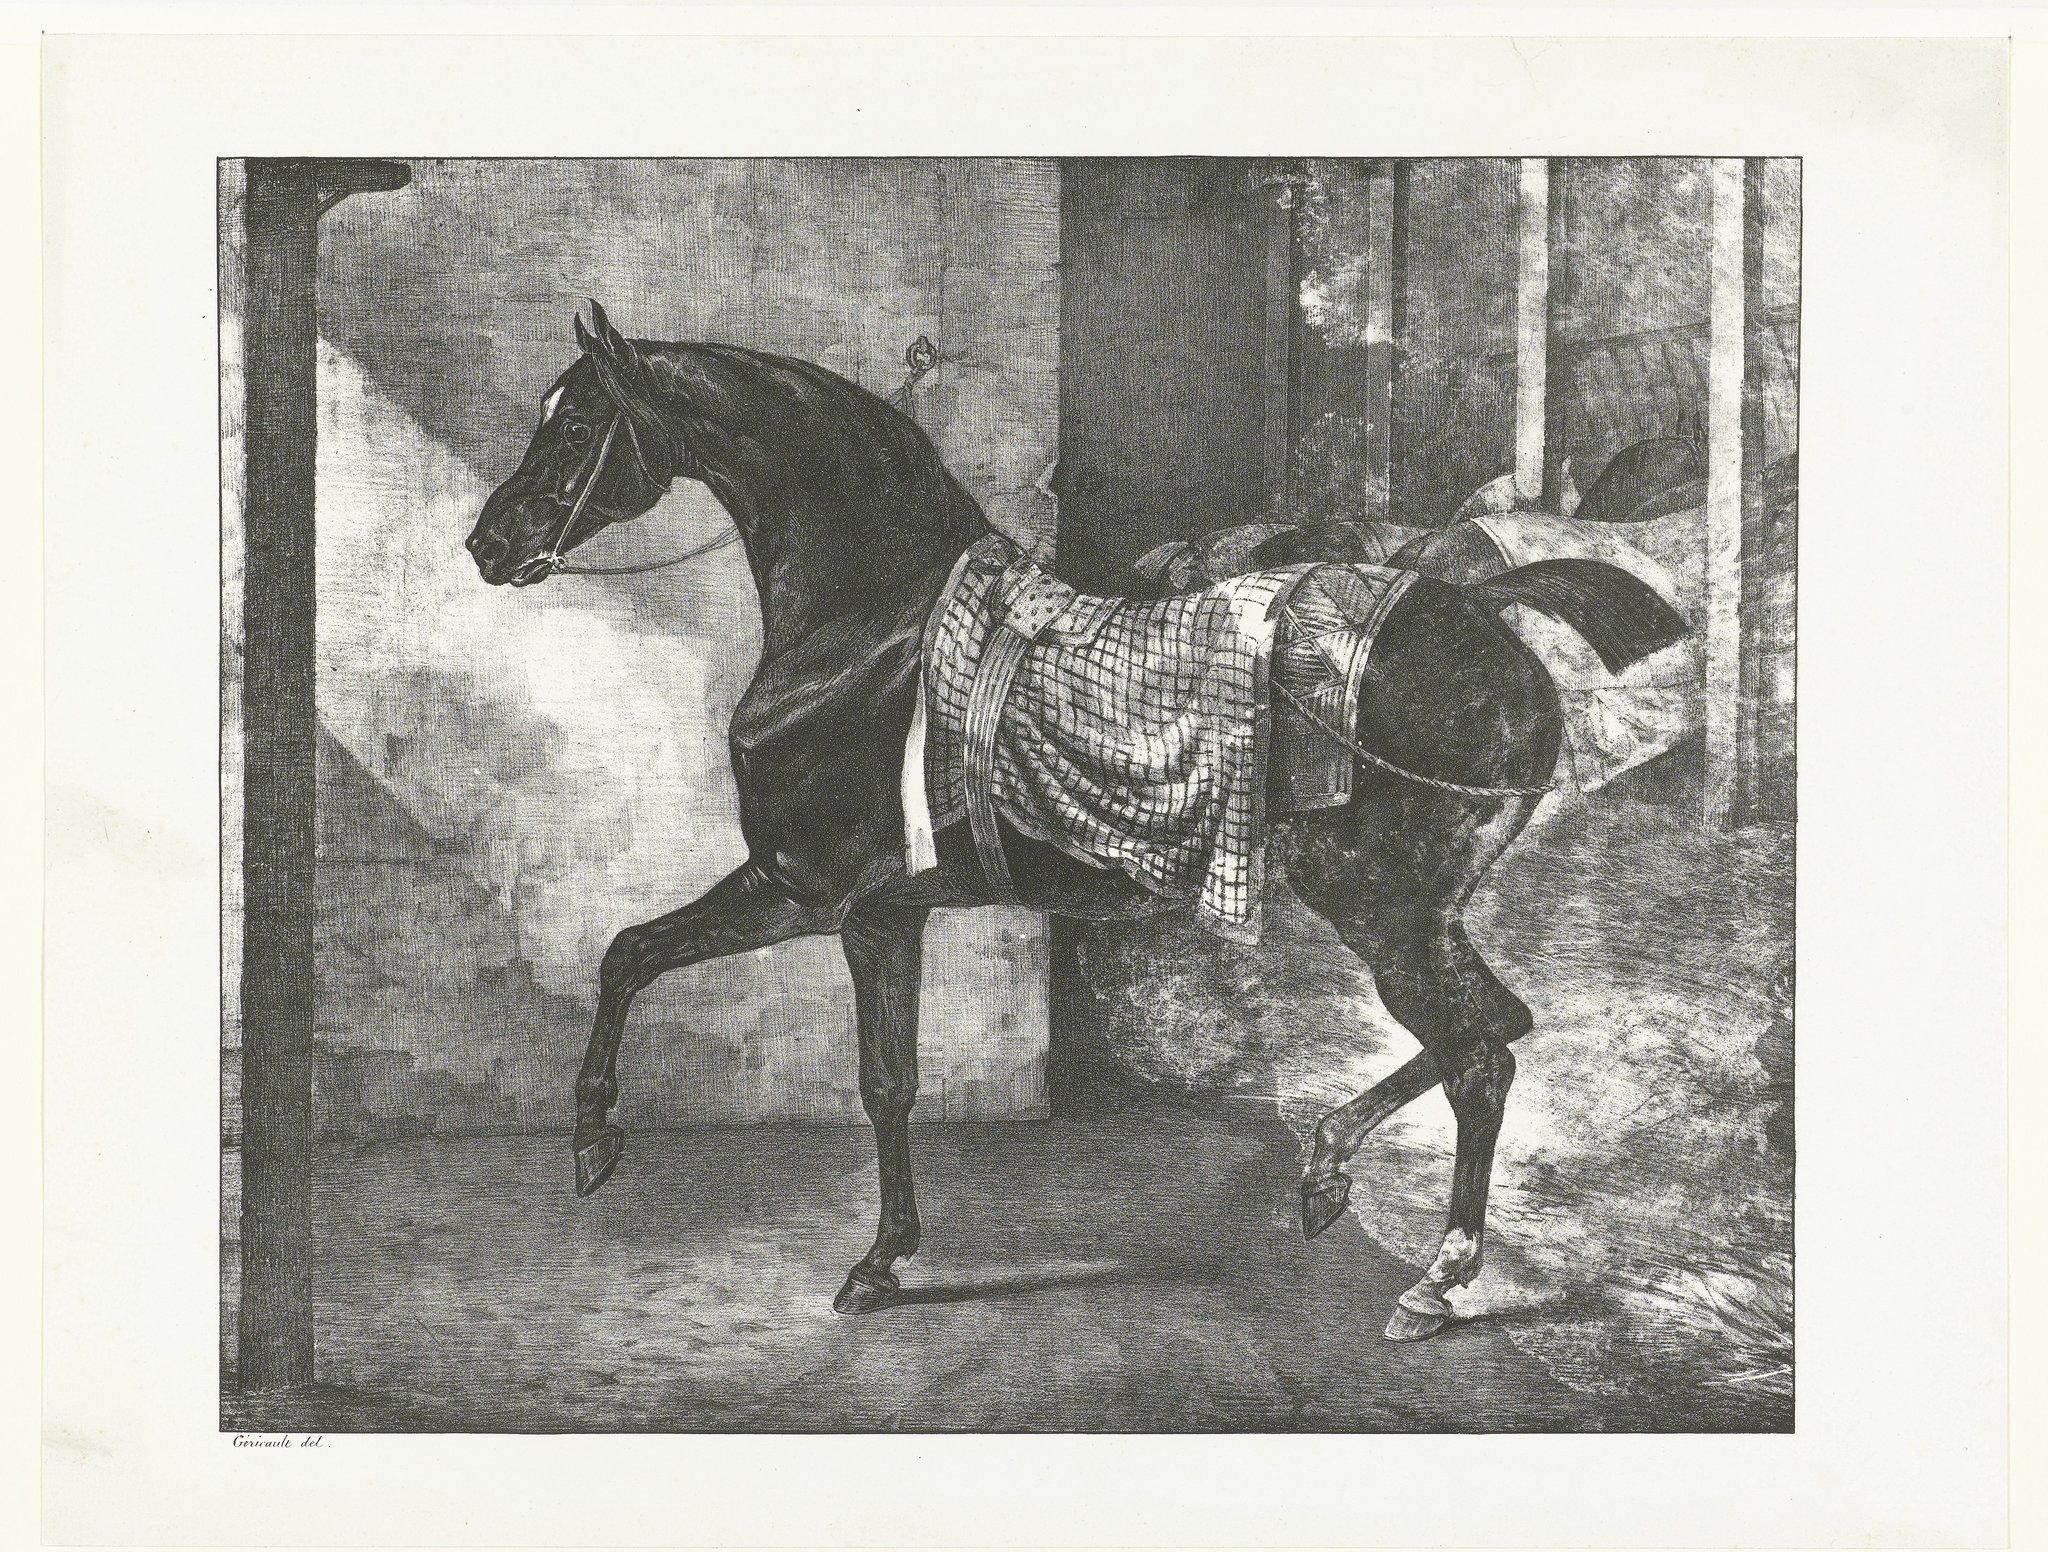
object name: print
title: Zwart volbloedpaard in een stal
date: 1822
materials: paper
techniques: lithograph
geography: paris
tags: racing stable, horse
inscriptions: collector's mark: Lugt 2228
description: Een zwart volbloedpaard met een dek om, van de zijkant gezien. In de stal staan nog enkele paarden in stands.